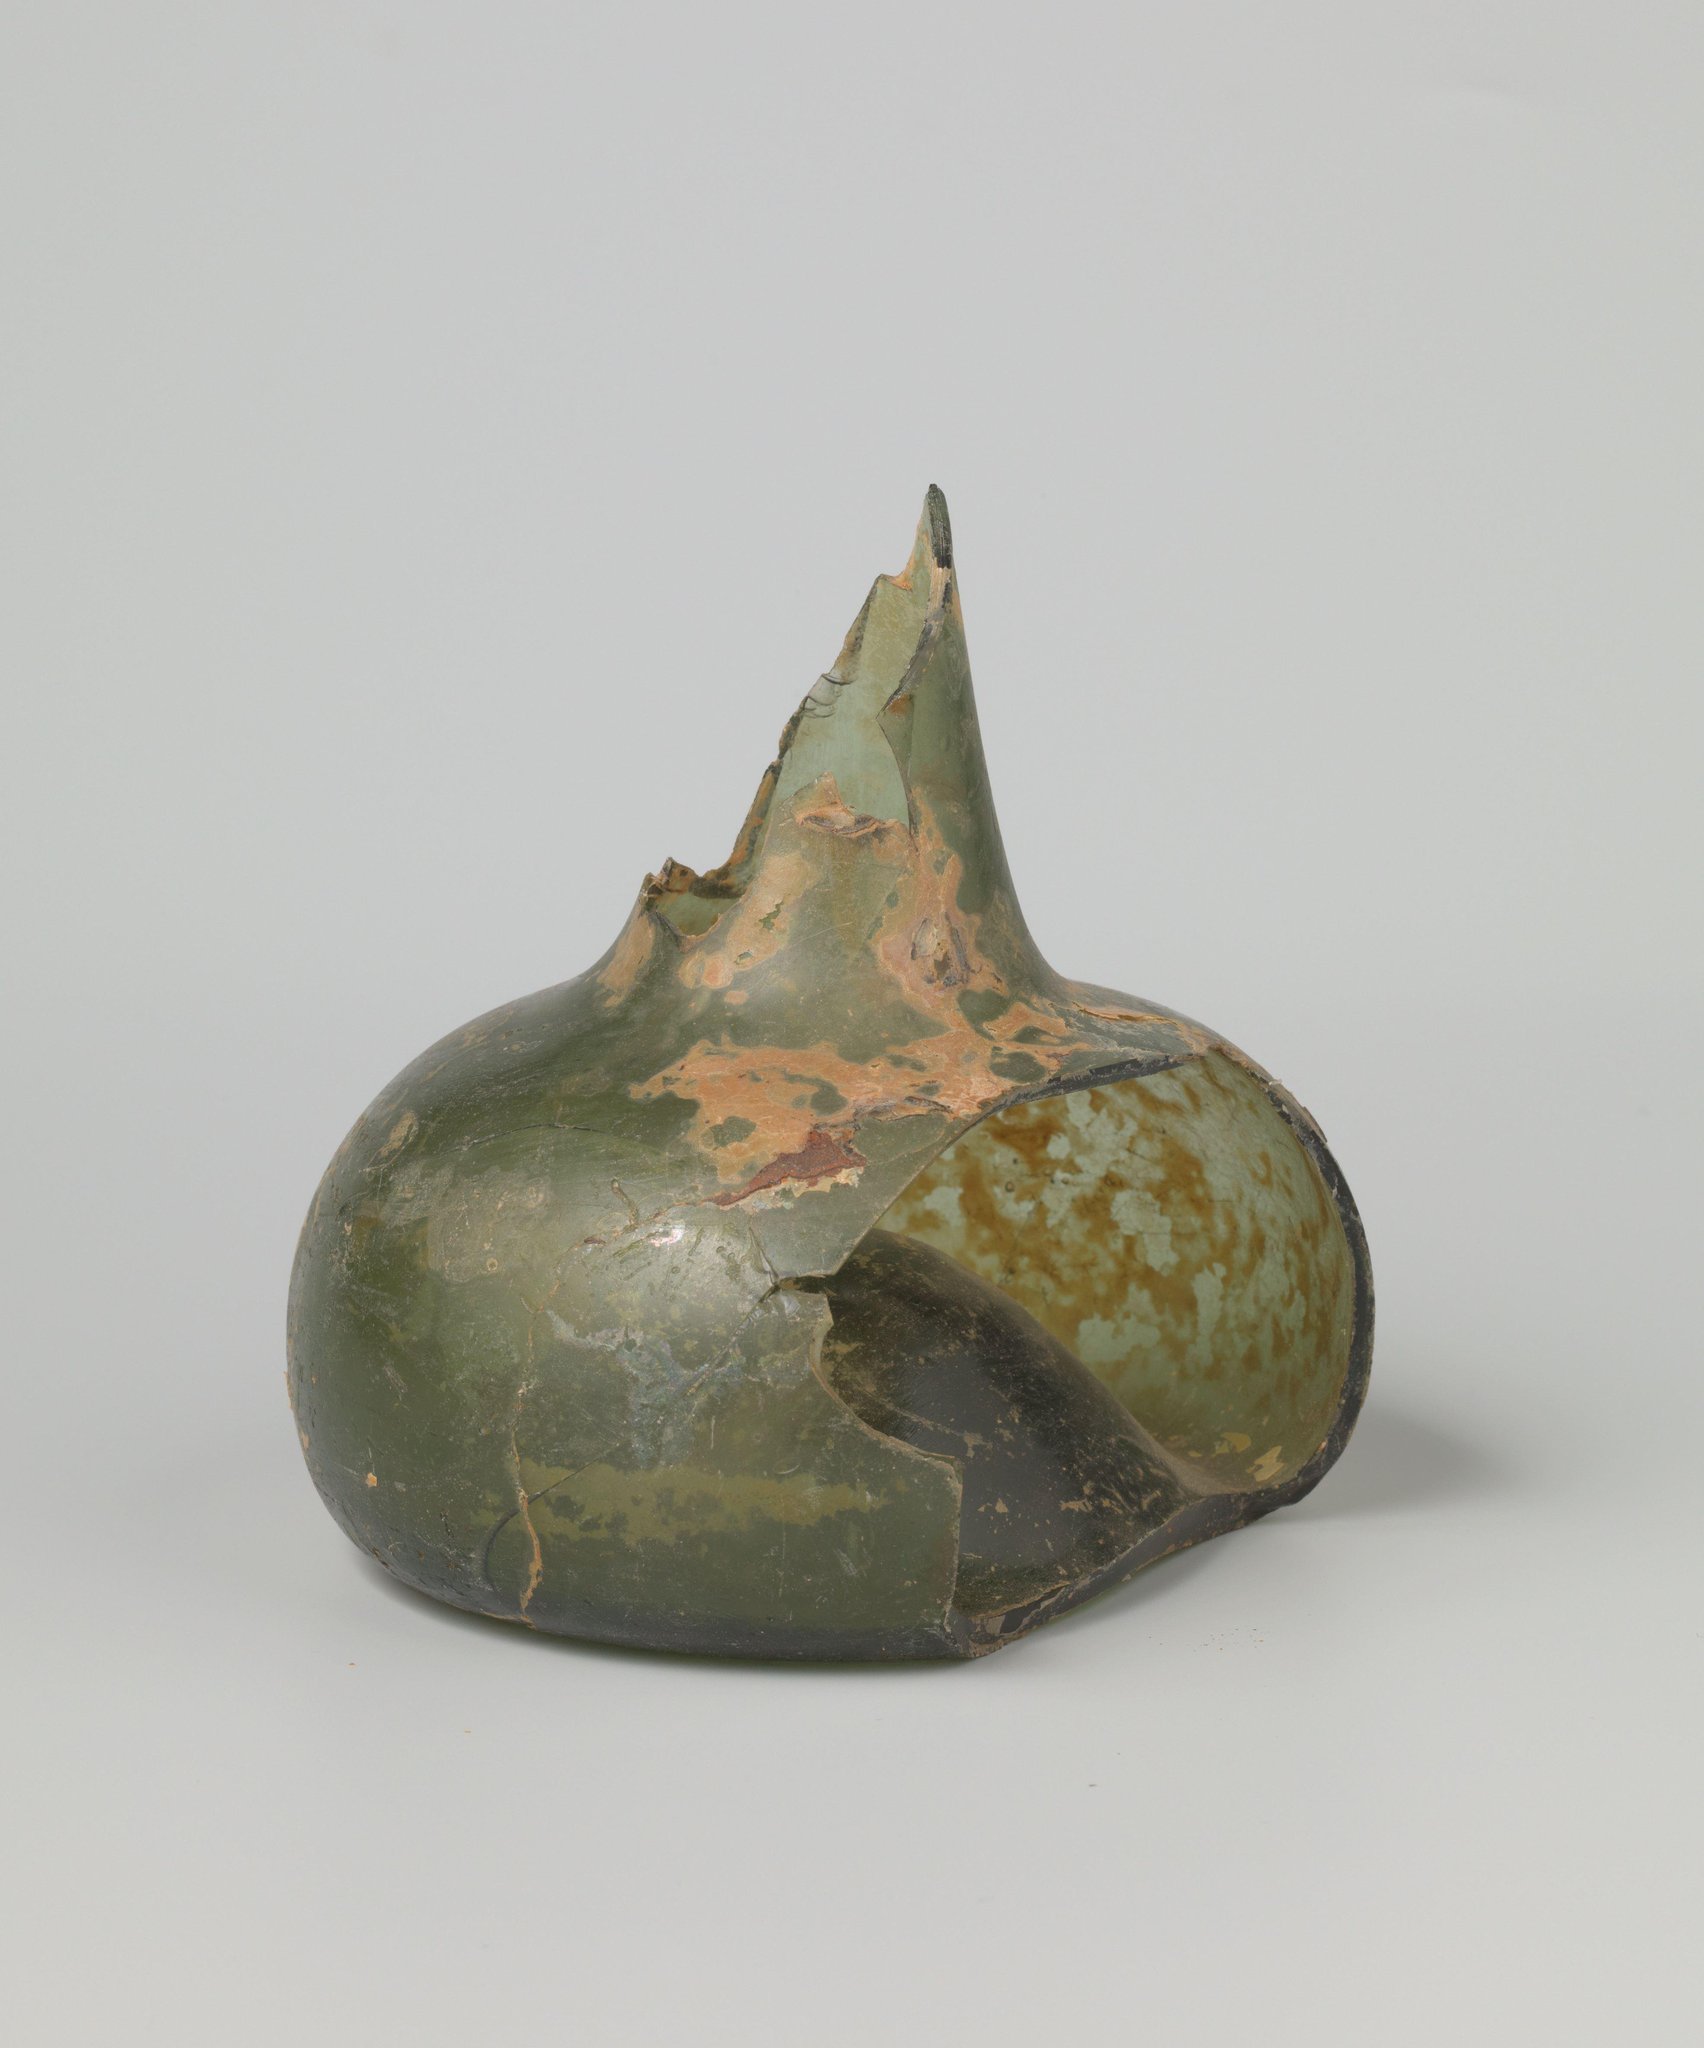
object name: wine bottle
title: Fragment wijnfles uit het wrak van de Oost-Indiëvaarder Hollandia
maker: Anonymous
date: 1700-1743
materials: glass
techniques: green glass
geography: netherlands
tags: verenigde oostindische compagnie, hollandia (schip), annet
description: Wine bottle, continental production, onion-shaped, mouth missing; tcs-kick-up.